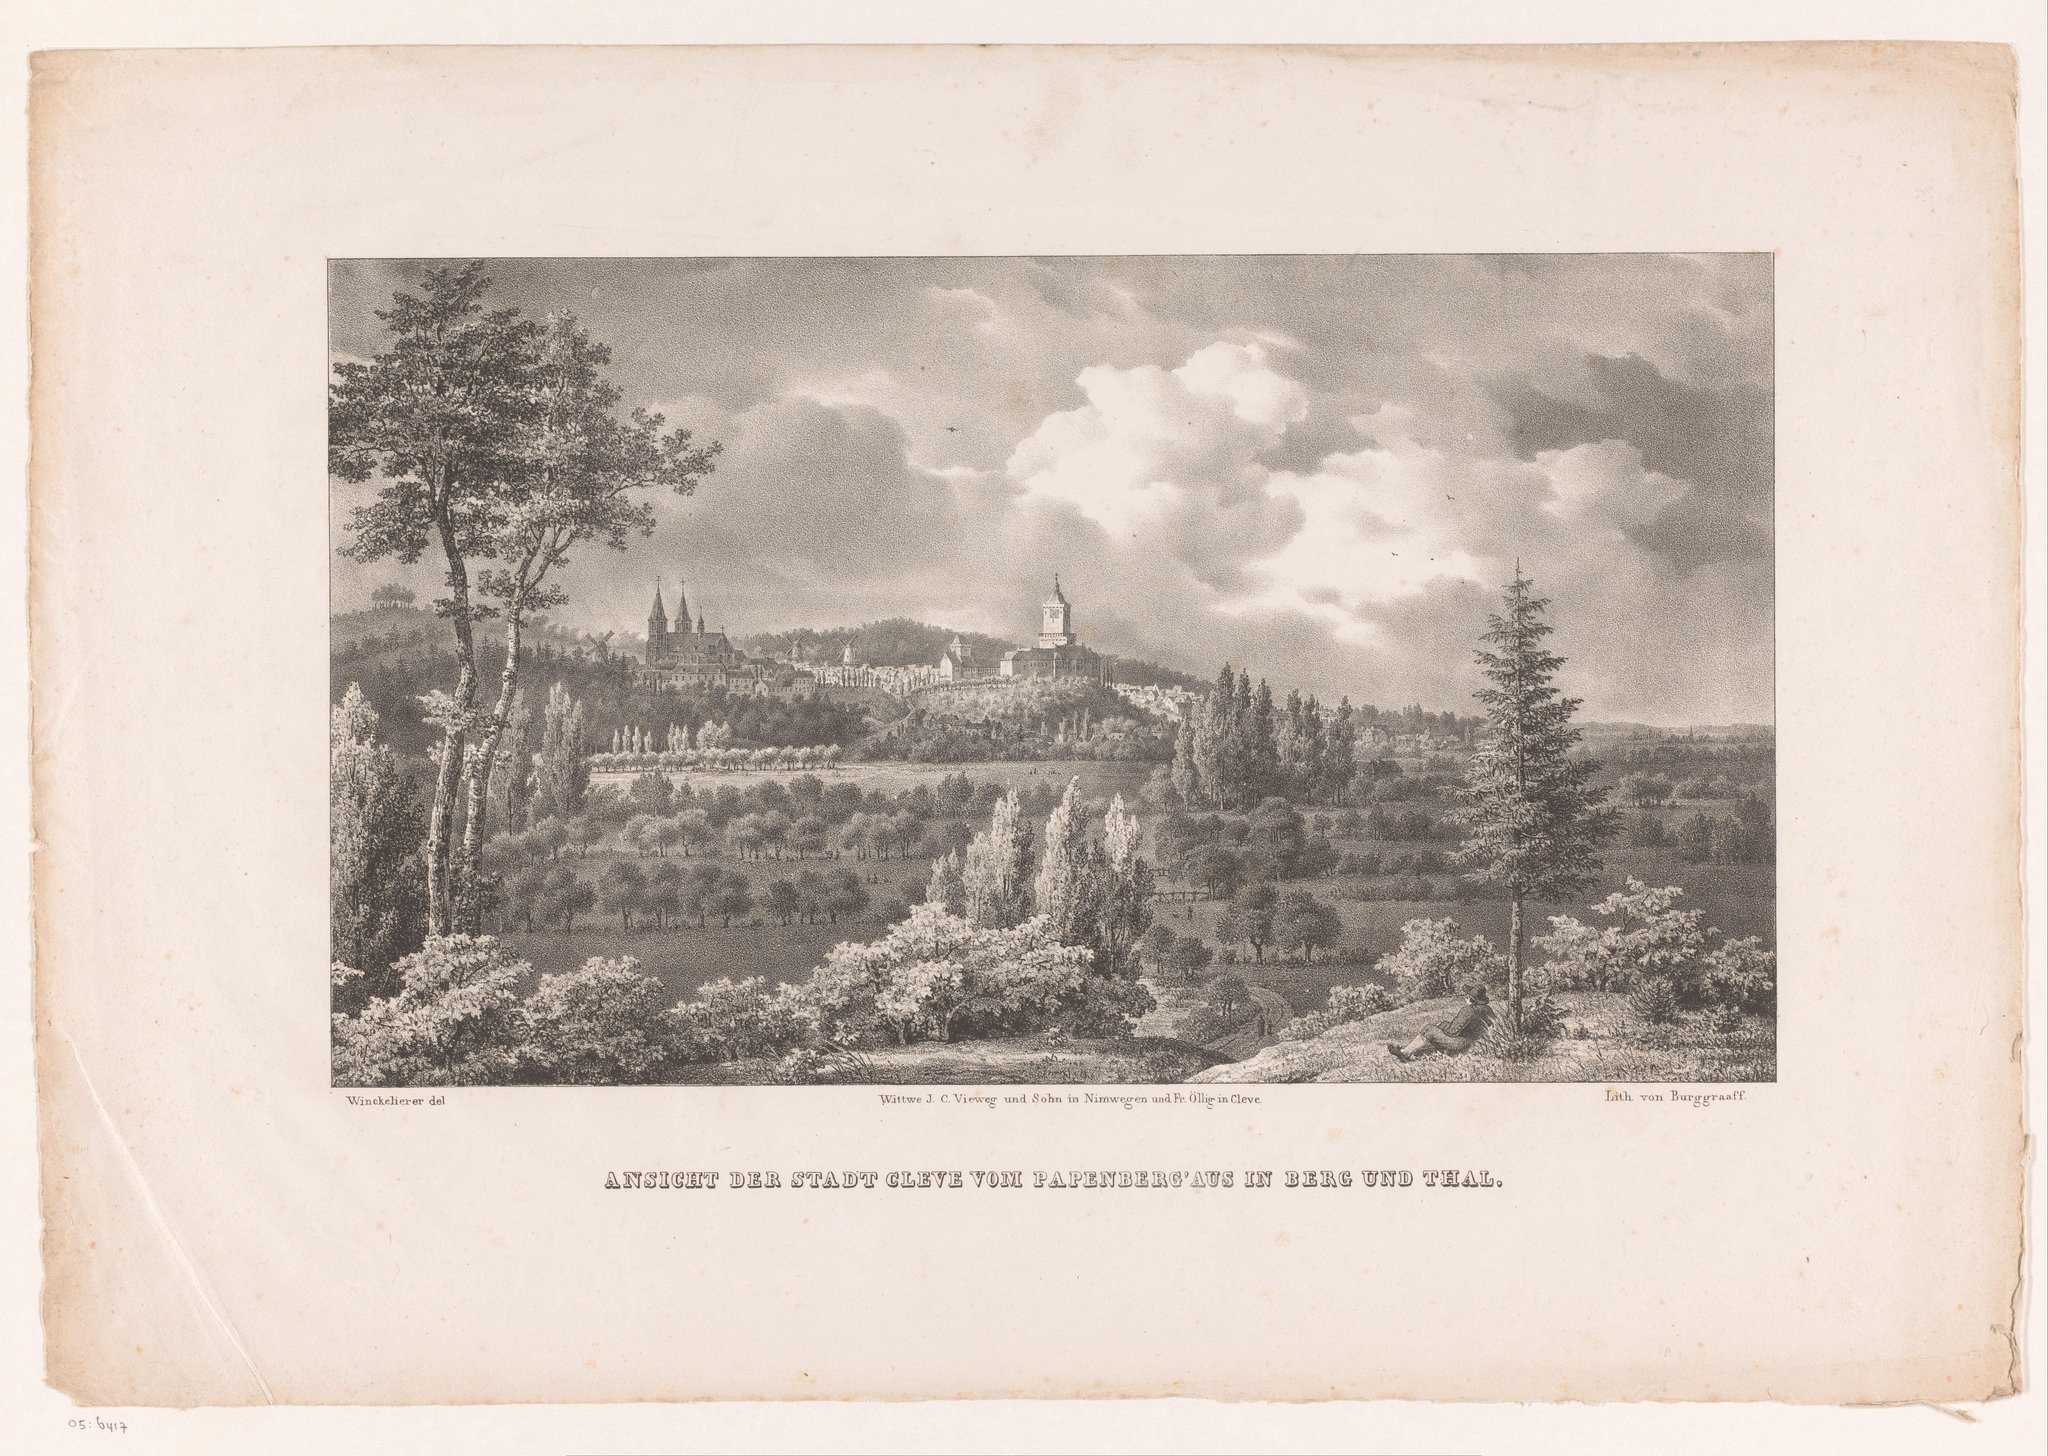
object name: print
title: Ansicht der Stadt Cleve vom Papenberg'aus in berg und thal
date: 1825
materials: paper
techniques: lithograph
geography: cleves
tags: city-view, and landscape with man-made constructions, church (exterior), windmill in landscape, cleves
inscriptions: collector's mark: Lugt 2228